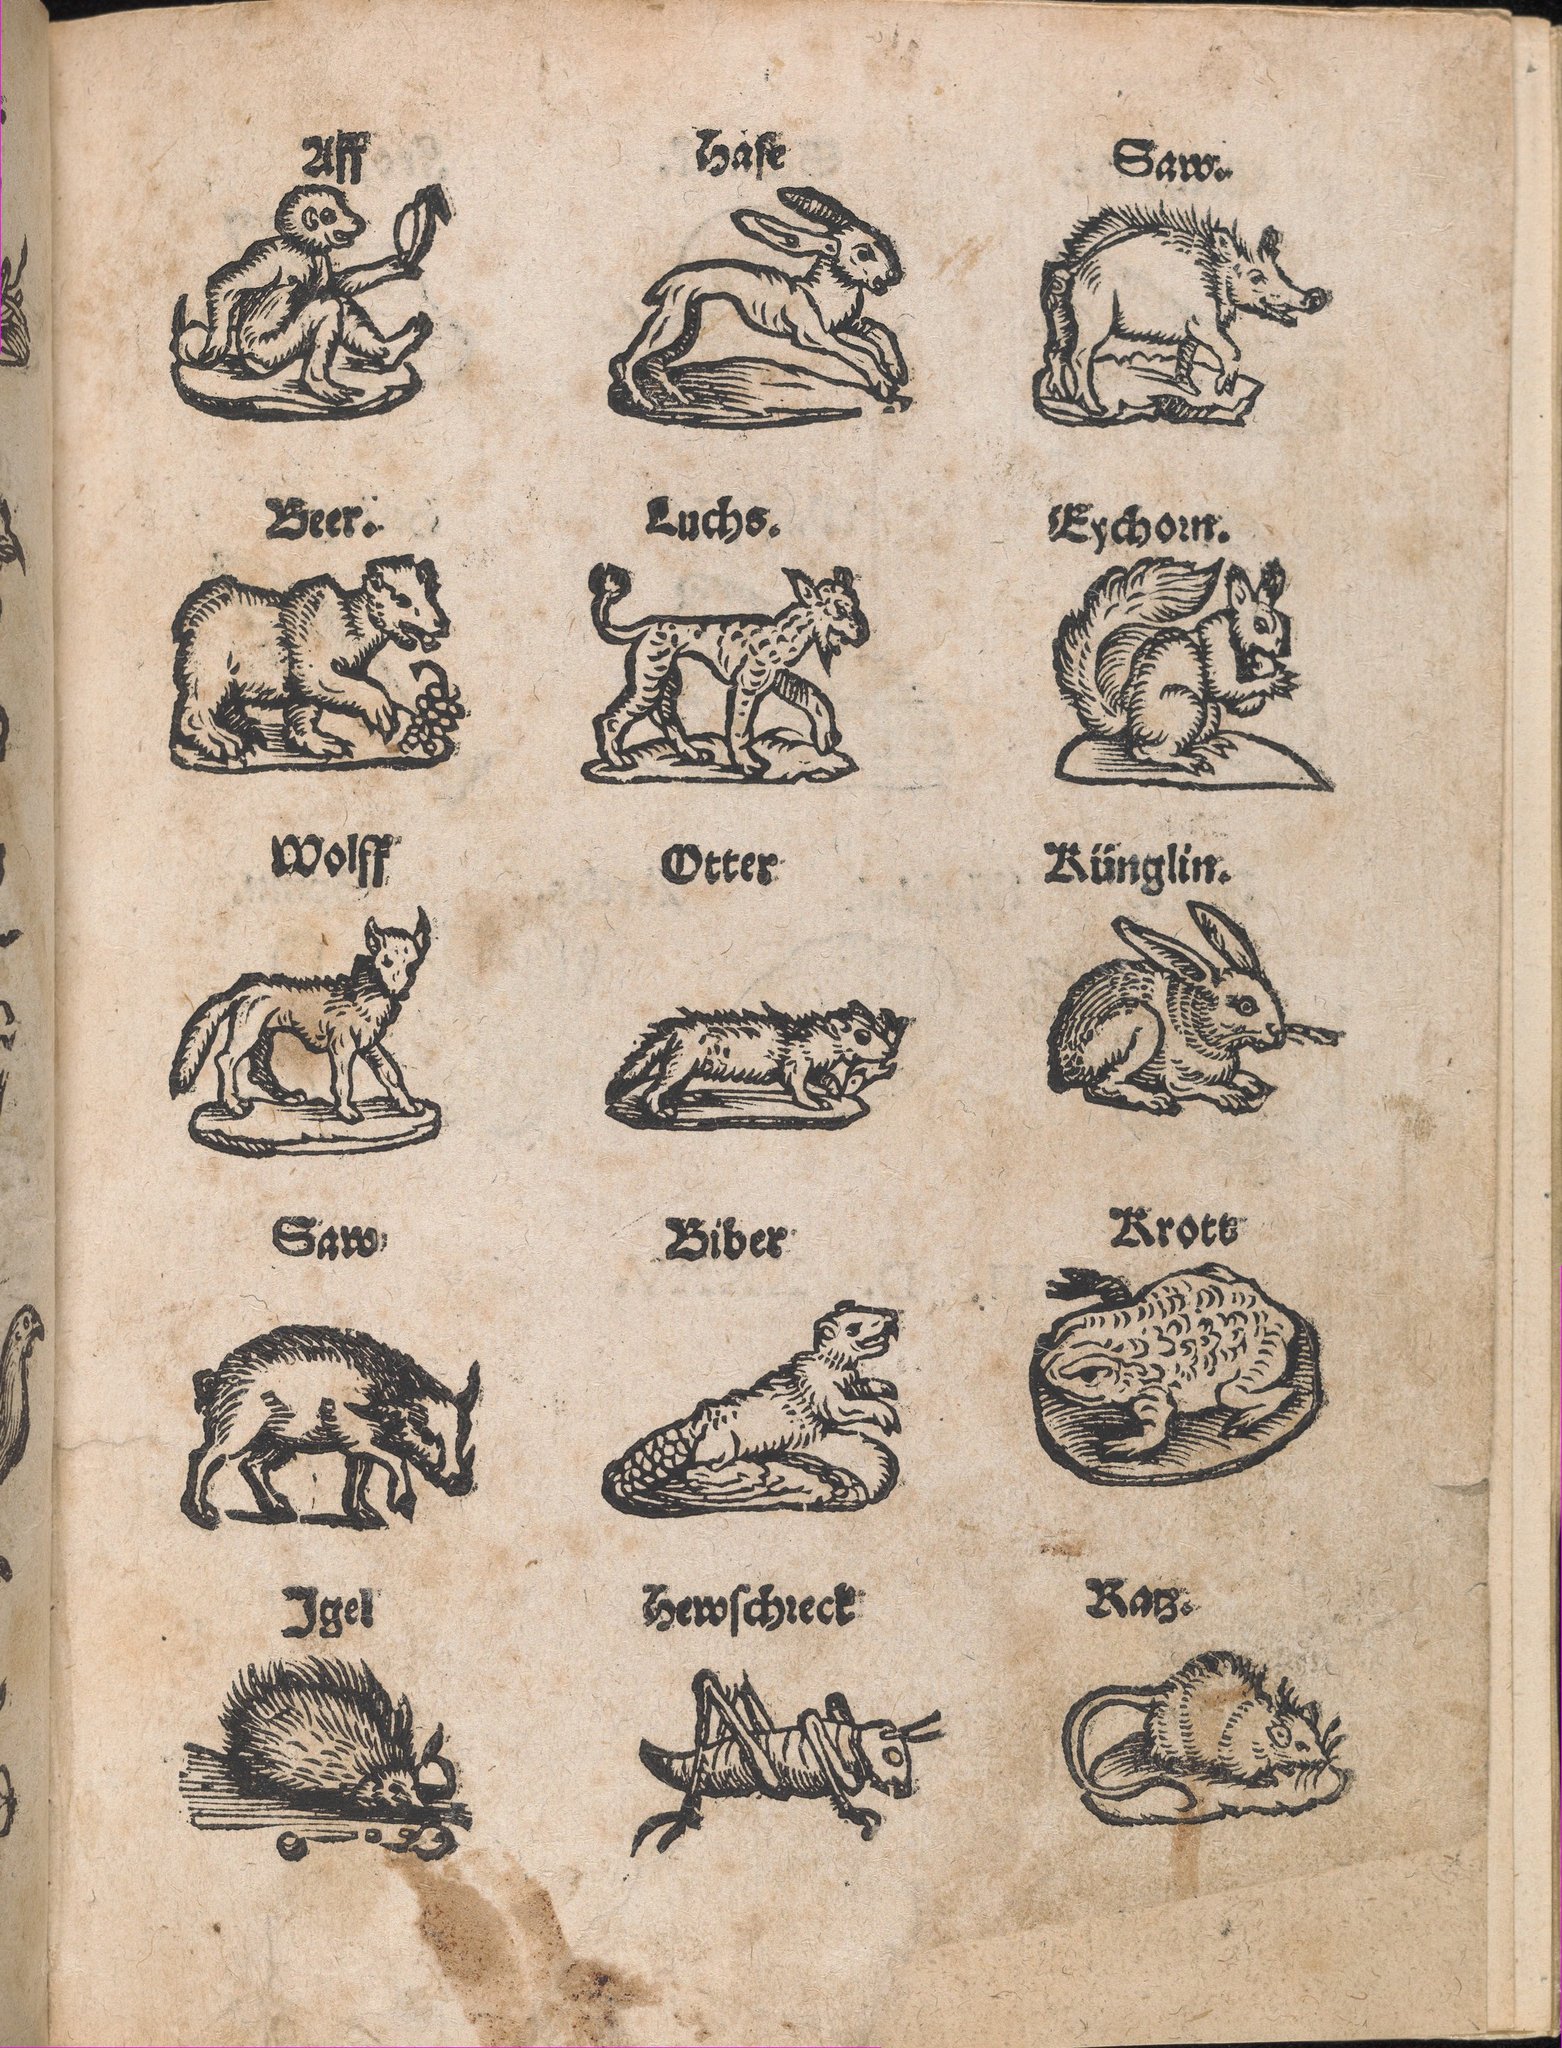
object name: book print ornament architecture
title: Modelbuch aller Art Nehens vn Stickens (Page 14r)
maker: christian egenolff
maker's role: publisher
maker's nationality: german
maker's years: 1502-1555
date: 1535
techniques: woodcut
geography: germany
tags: animals